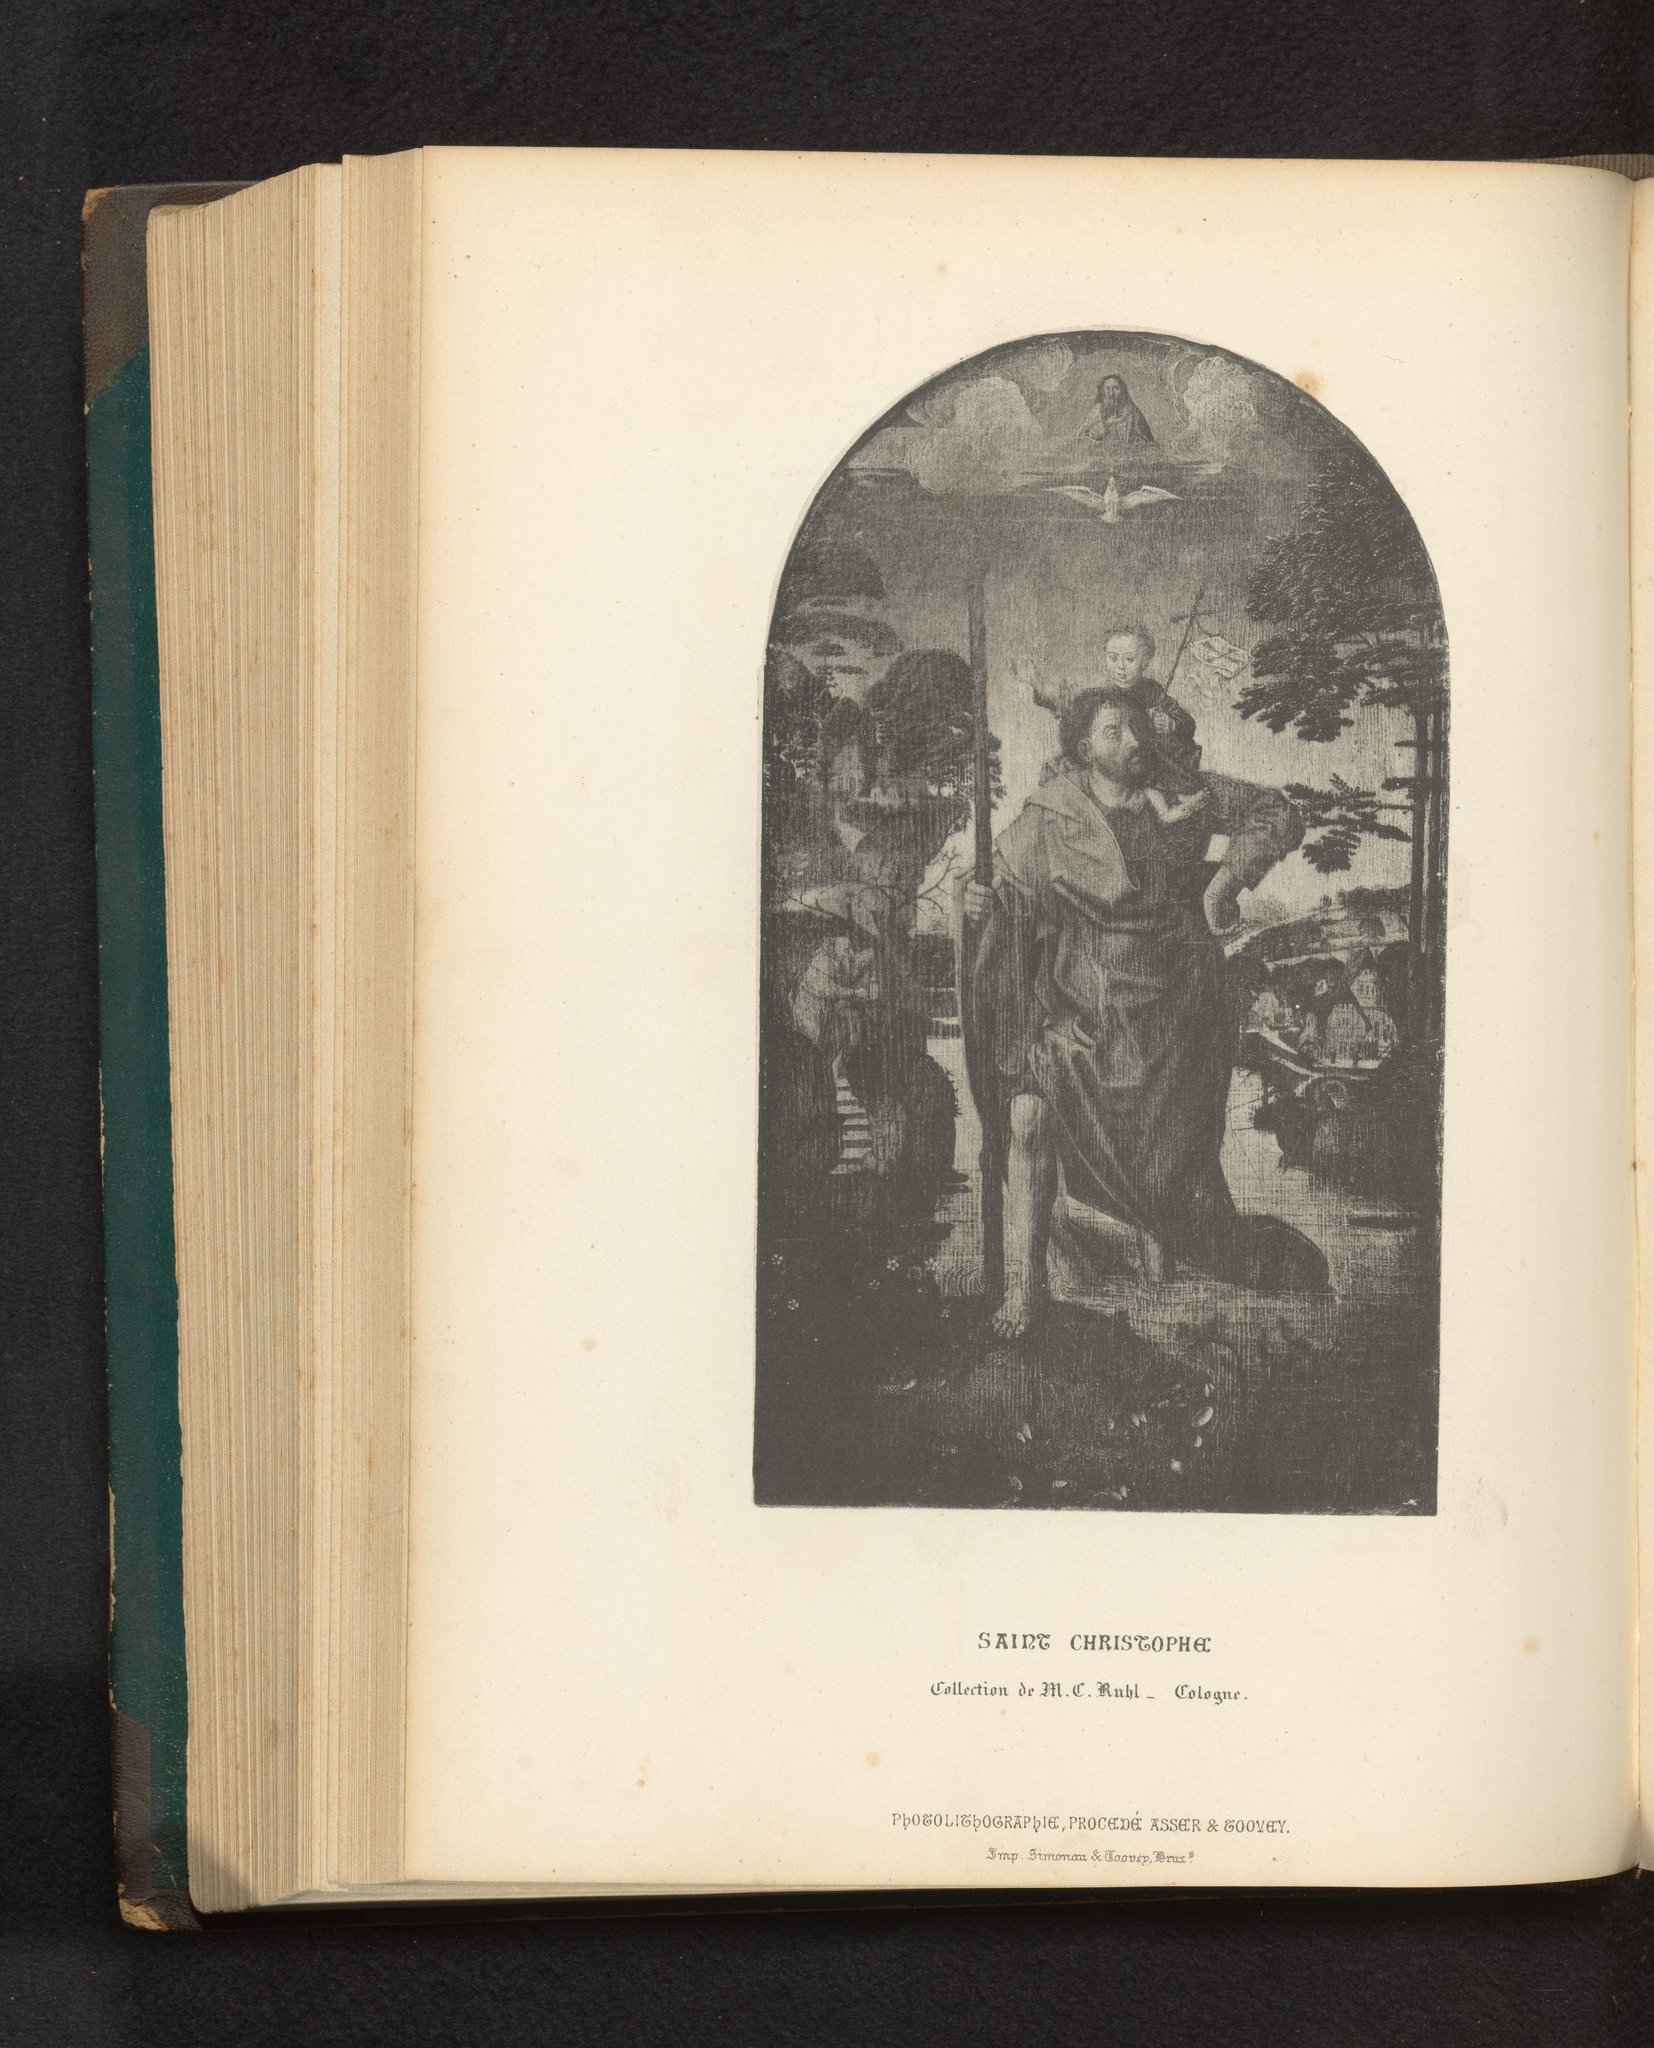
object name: page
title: Reproductie van een schilderij van de heilige Christoffel met Christus op zijn schouders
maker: Anonymous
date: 1858-1863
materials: paper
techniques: photolithography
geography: brussels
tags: st. christopher, with the infant christ on his shoulders, wading through the water and carrying his staff (palm-tree); sometimes a hermit stands on the further bank beside a chapel, a lantern in his hand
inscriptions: inscription: ‘Collection de M. C. Ruhl - Cologne.’